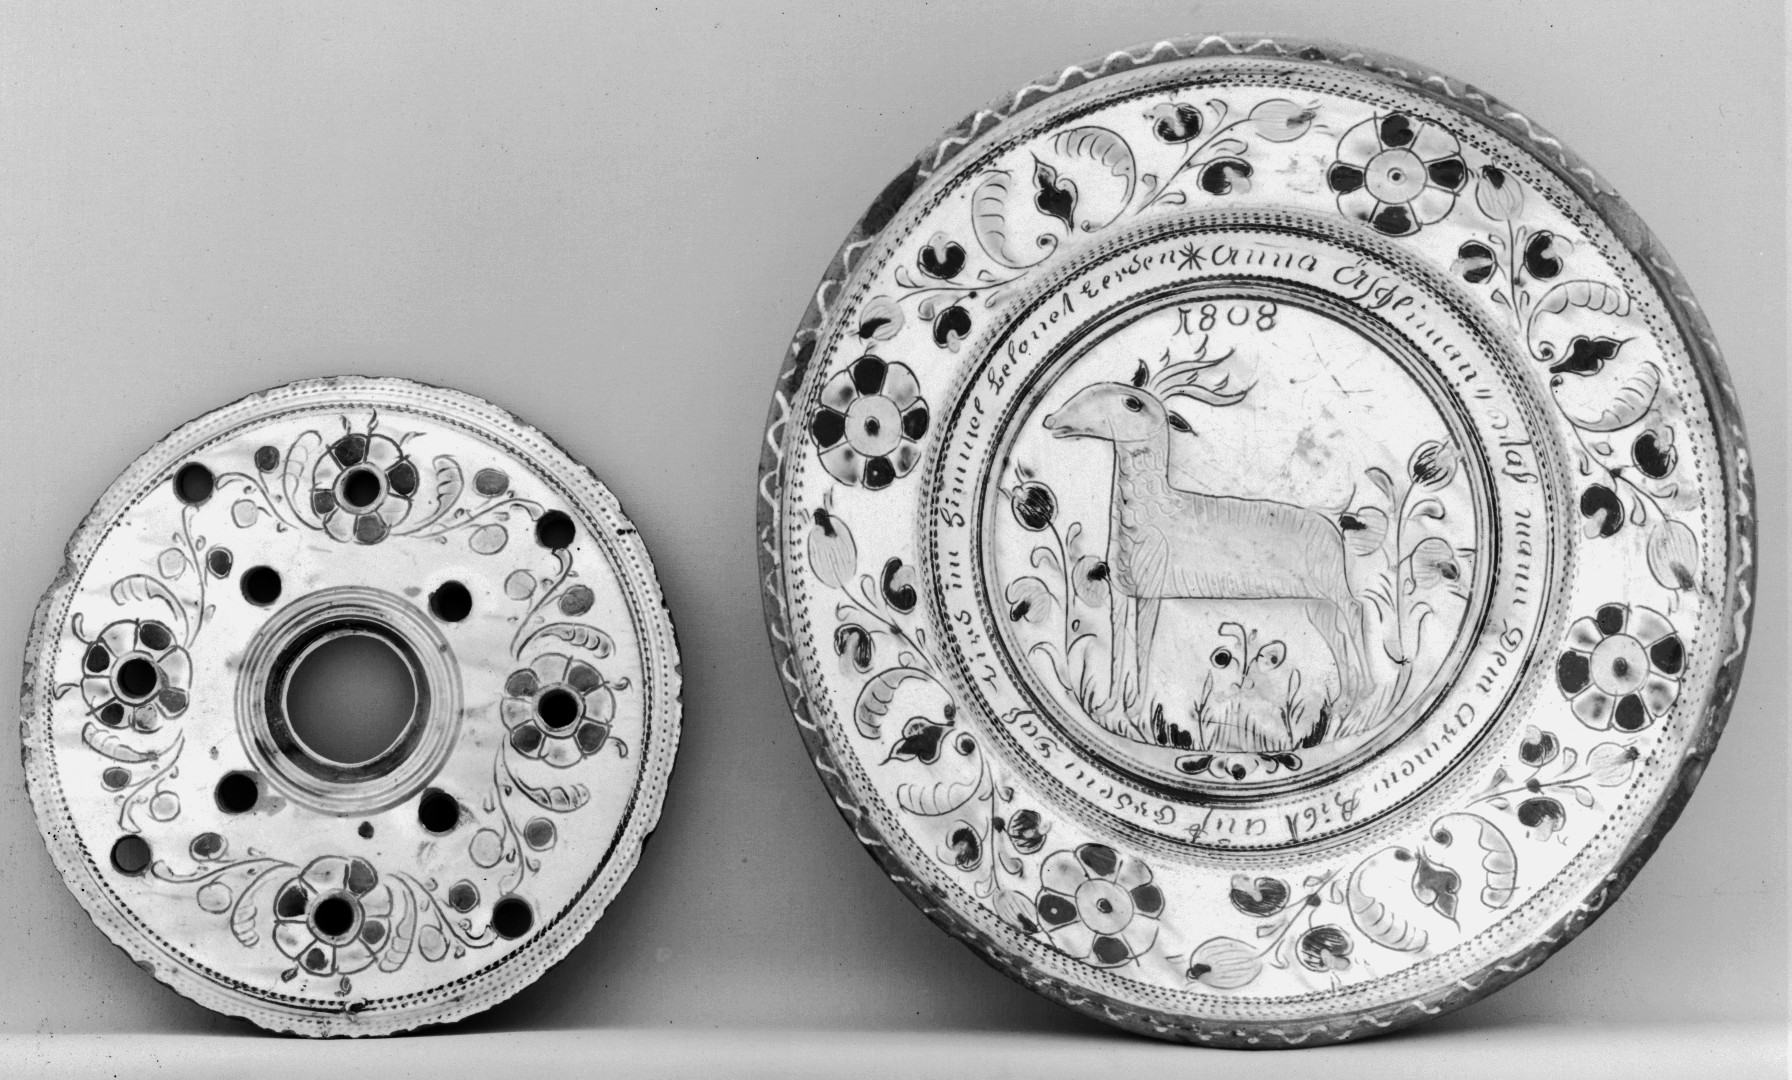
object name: plate or platter with drainer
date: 1808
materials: earthenware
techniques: glazing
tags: animals,flowers